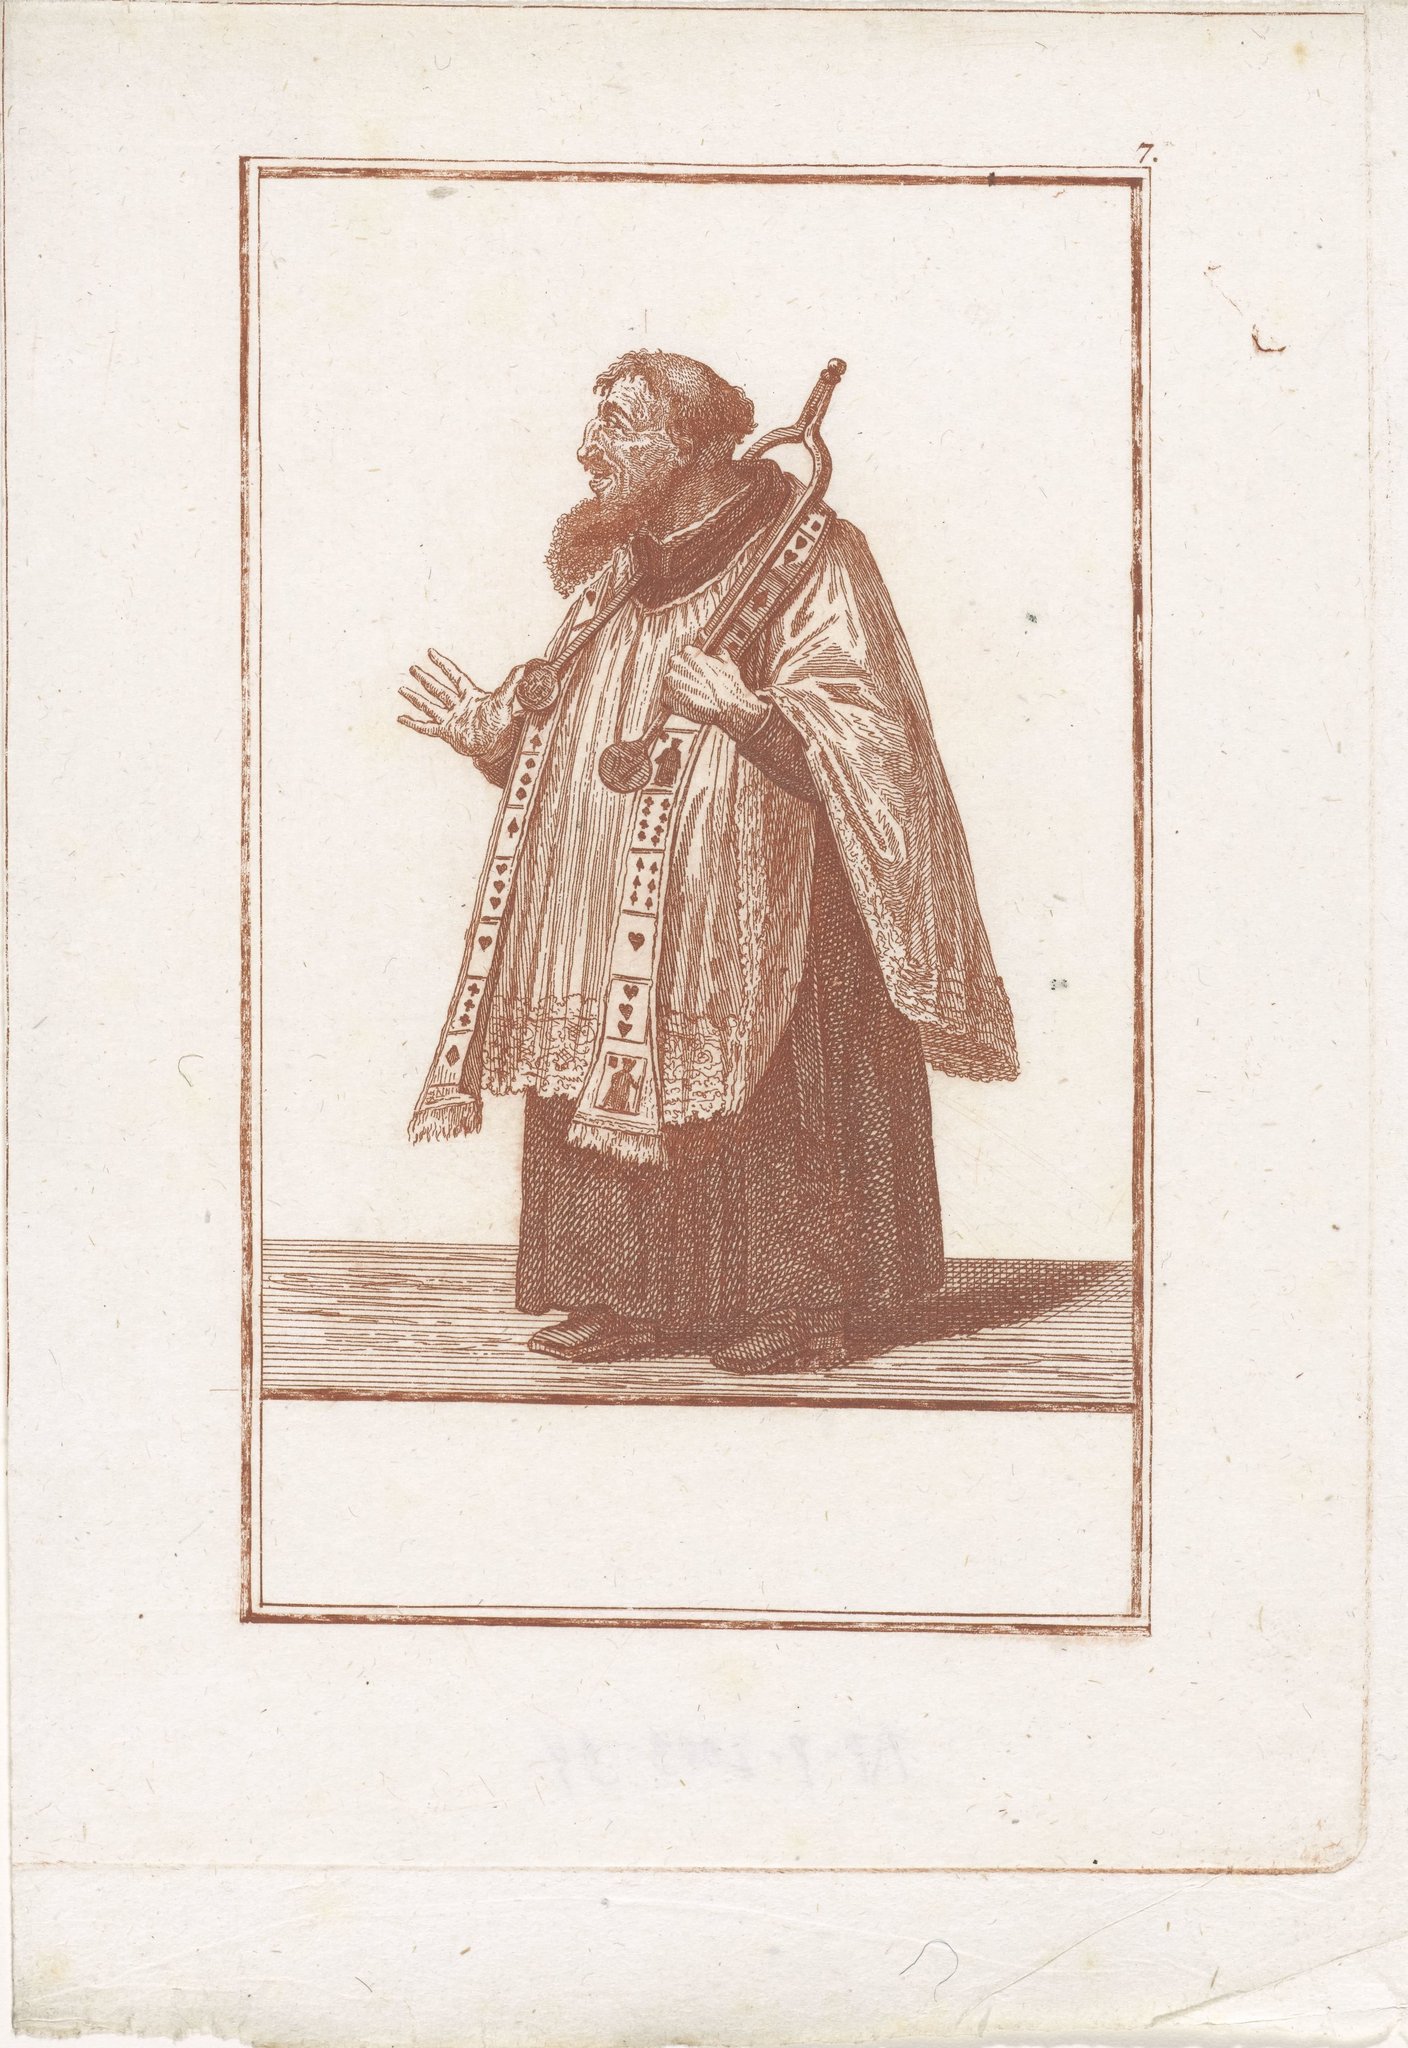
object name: print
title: Misbruiken van de katholieke geestelijkheid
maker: jacob gole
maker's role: print maker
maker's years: 1660-1724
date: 1724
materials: paper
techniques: etching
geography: amsterdam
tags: andiron, fire-dog, monk(s), friar(s), playing-cards, (aspects of) christian religion or the church (as institution) ridiculed, criticized, or caricaturized, stole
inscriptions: collector's mark: Lugt 2760, collector's mark: Lugt 2228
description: Een bebaarde monnik. Over zijn pij draagt hij de witte albe en een stola, gemaakt van speelkaarten. Om zijn nek een haardijzer. De prent is deel van een 50-delige serie met als onderwerp de misbruiken van de katholieke geestelijkheid.